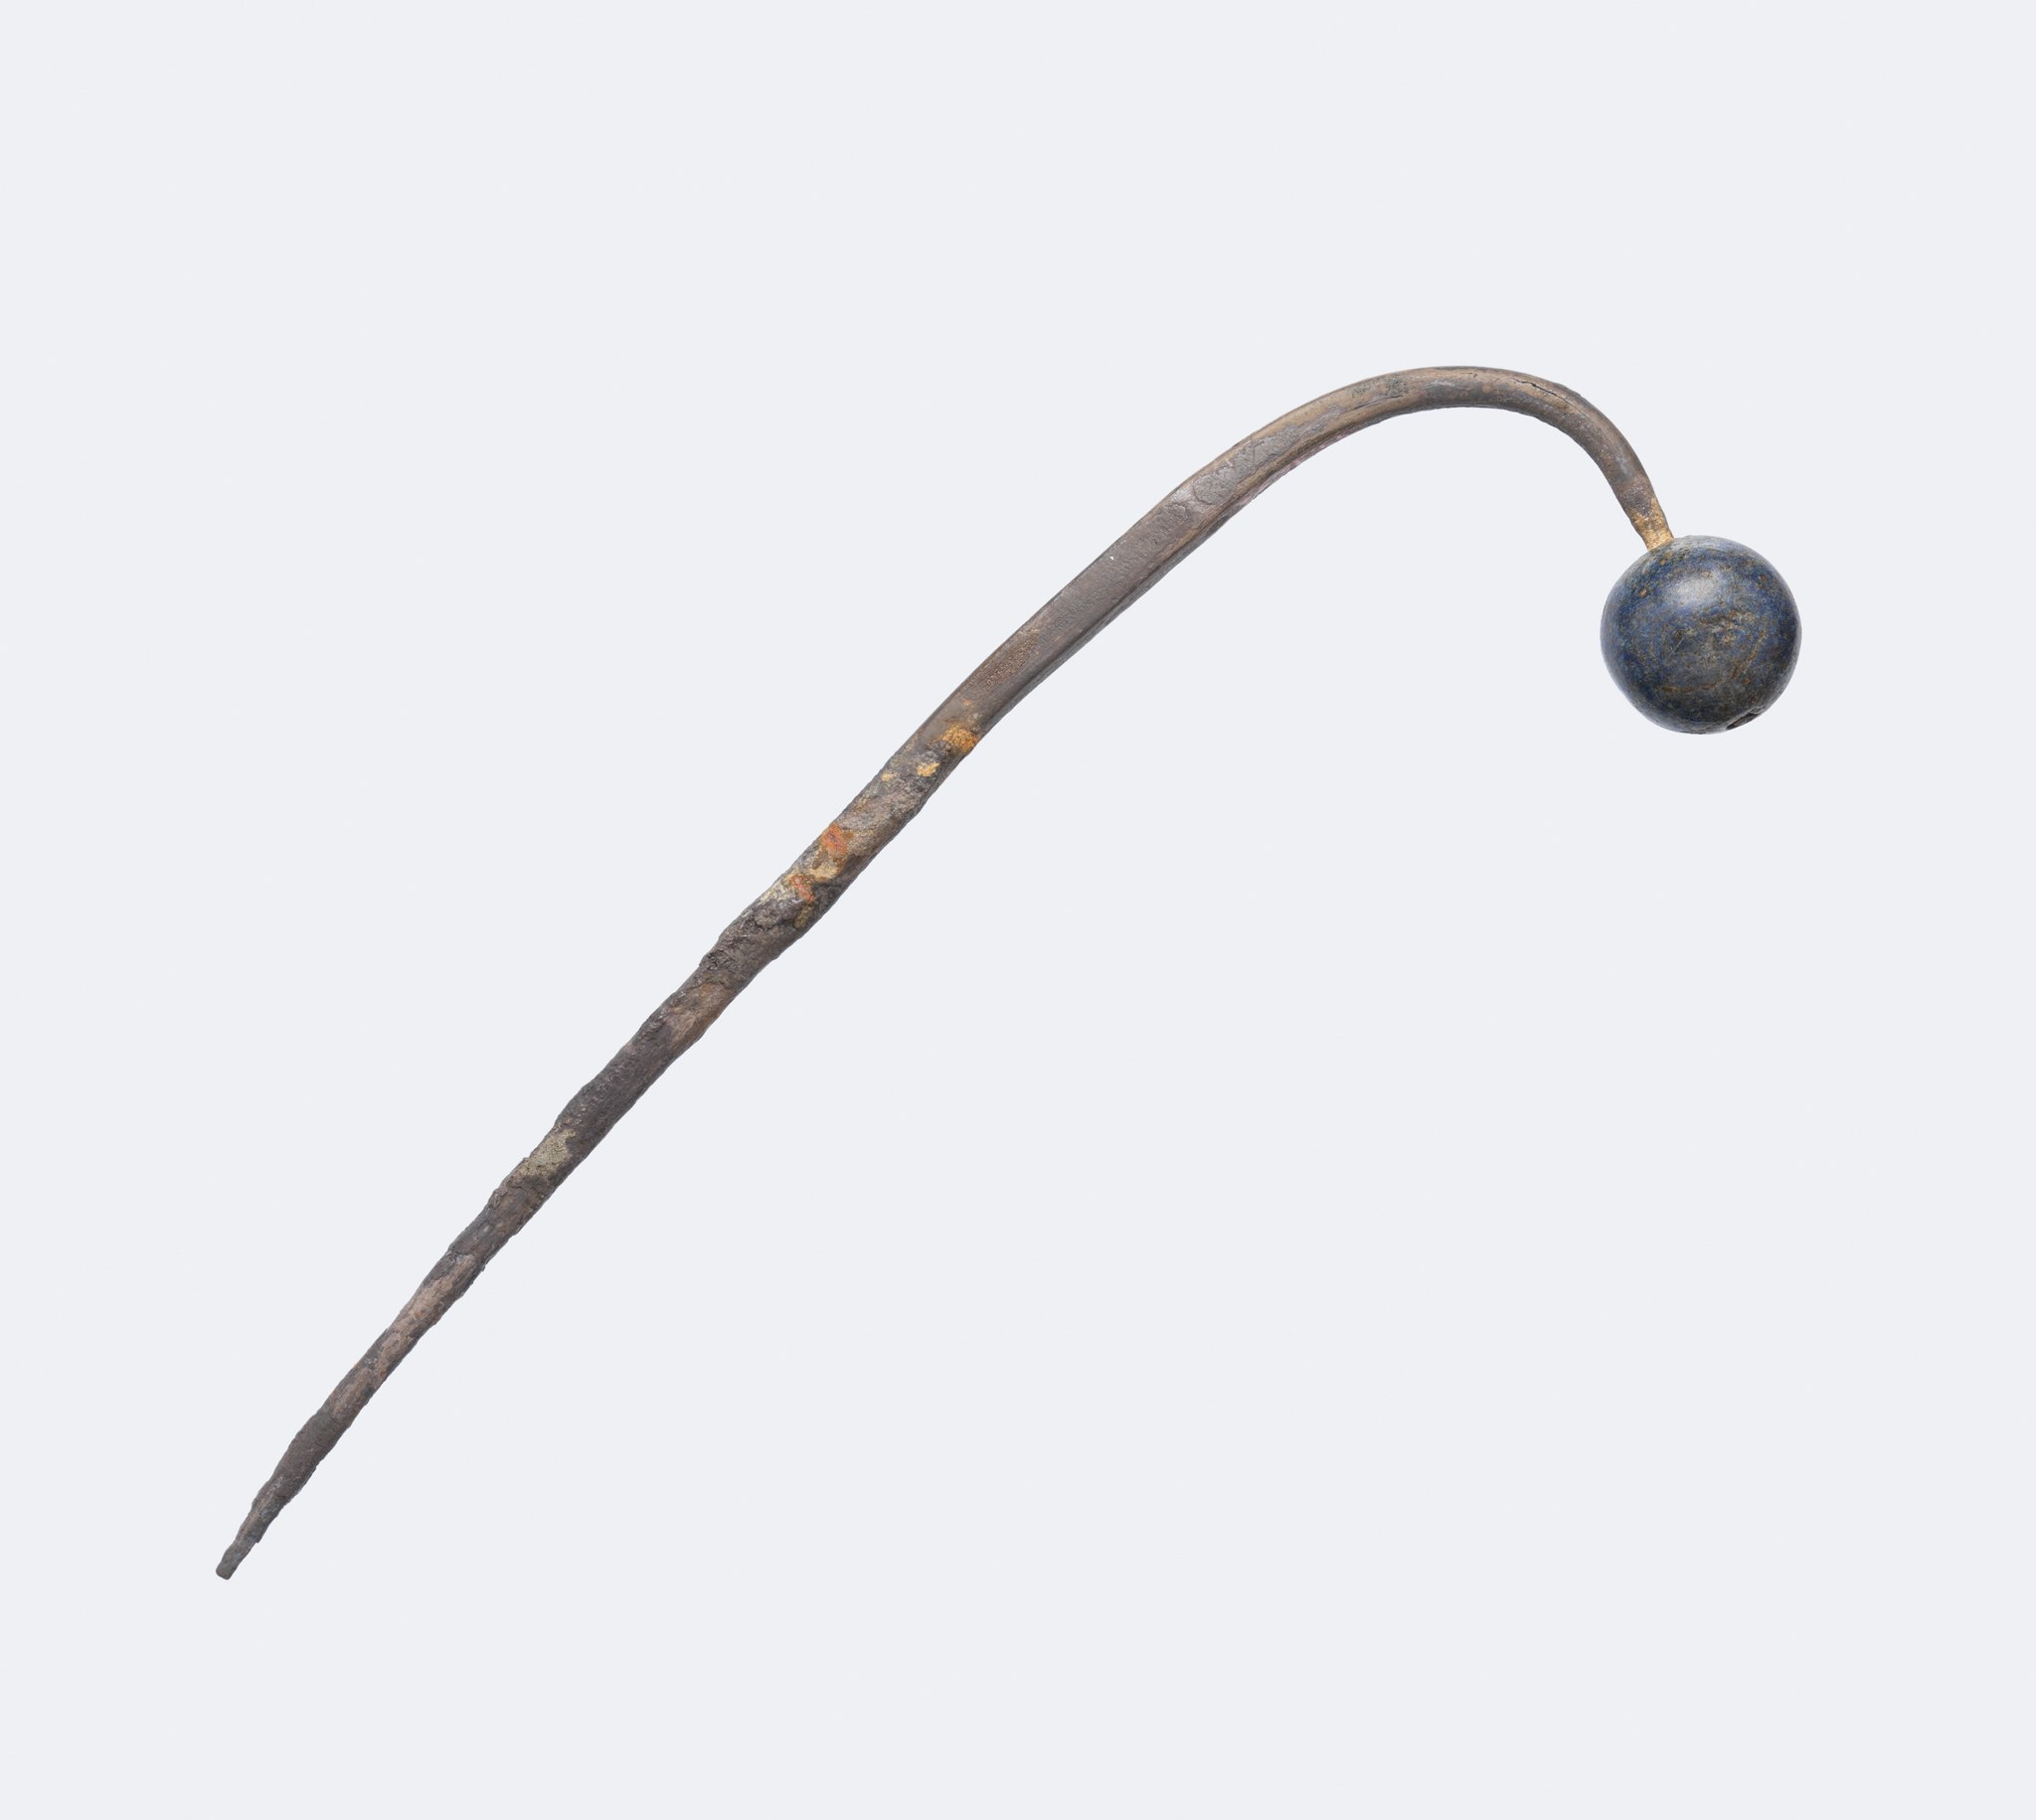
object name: pin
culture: sumerian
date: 2600-2500 BCE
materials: lapis lazuli, silver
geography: mesopotamia